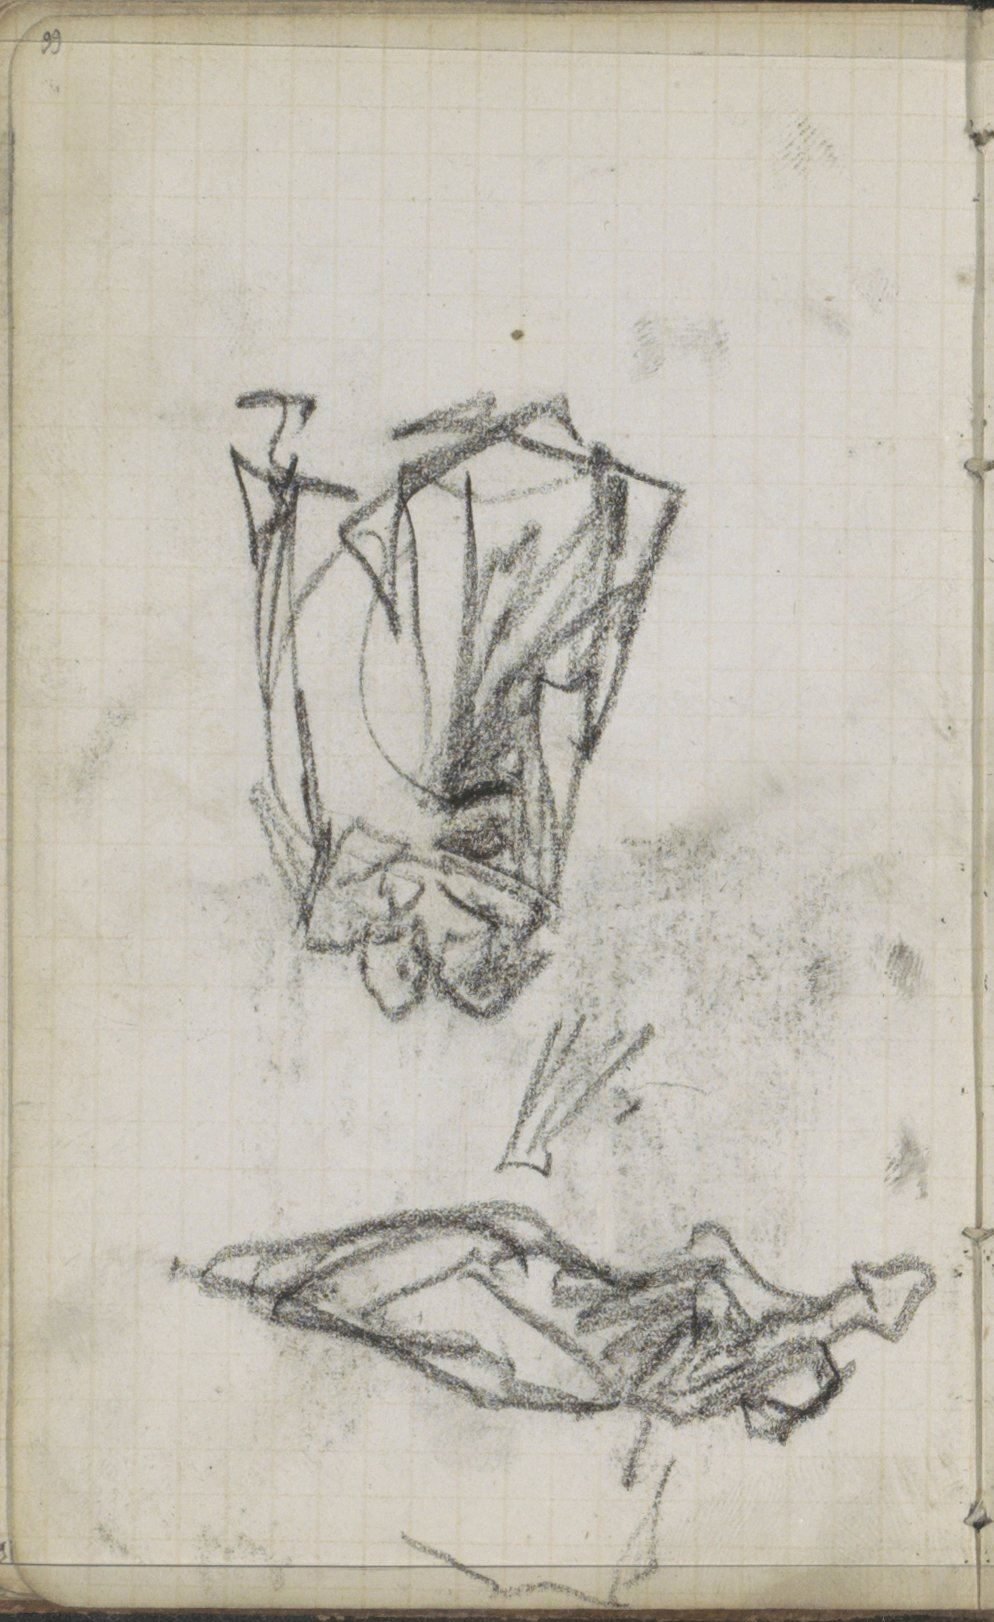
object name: sketchbook leaf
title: Liggende figuur en omhelzende figuren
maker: marius bauer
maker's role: draughtsman, print maker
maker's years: 1867-1932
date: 1879-1885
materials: chalk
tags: embracing each other, kissing, lying figure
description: Pagina 99 uit een schetsboek met 58 bladen.